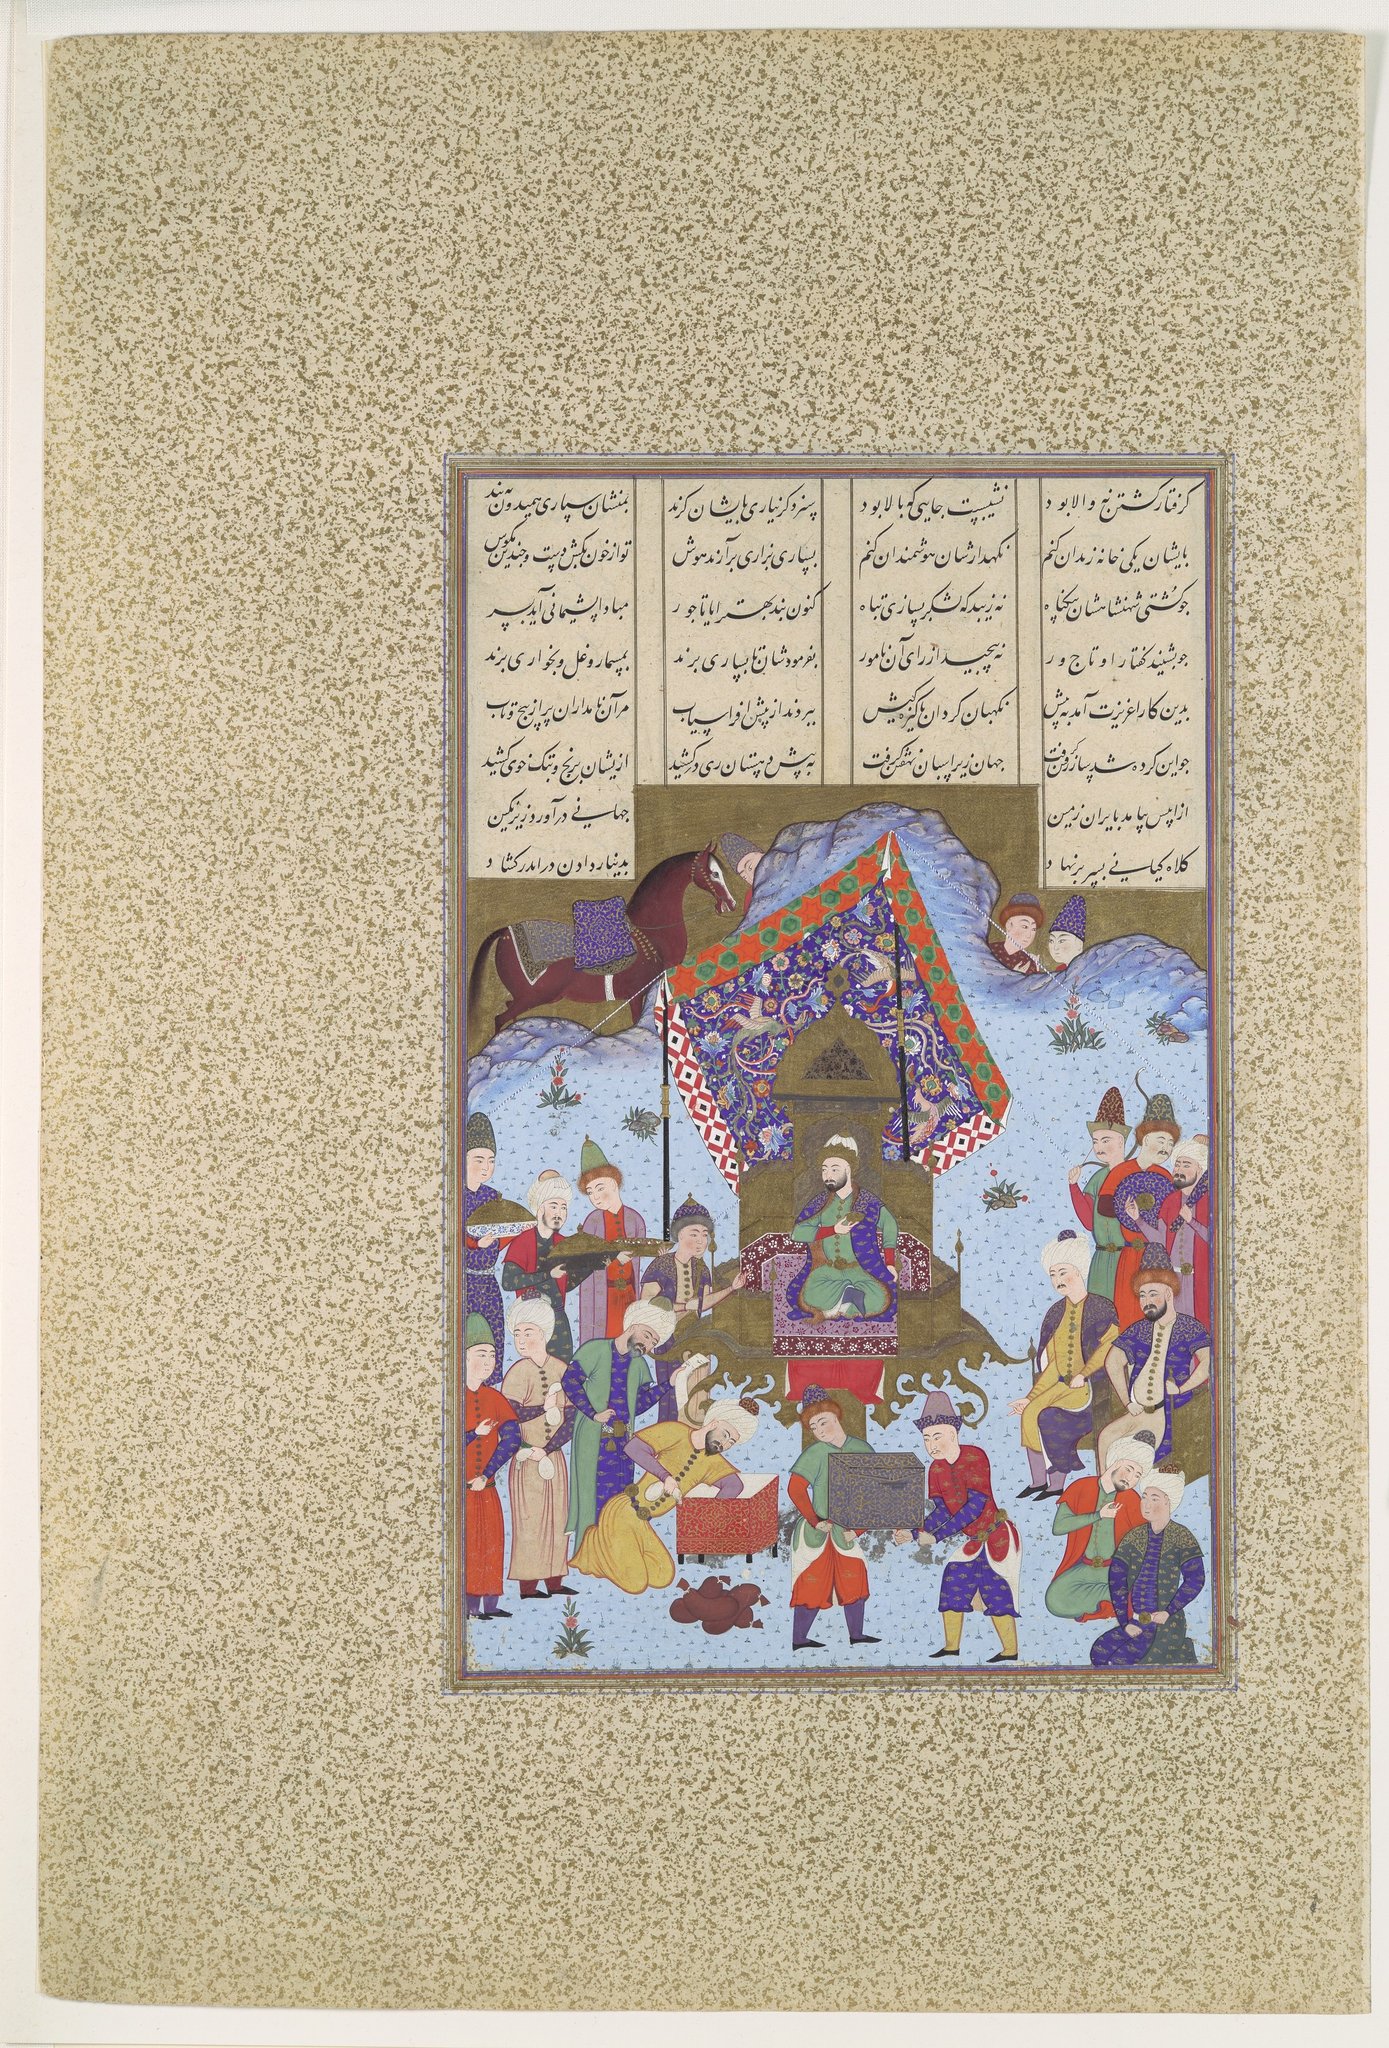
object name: folio from an illustrated manuscript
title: "Afrasiyab on the Iranian Throne", Folio 105r from the Shahnama (Book of Kings) of Shah Tahmasp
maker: abu'l qasim firdausi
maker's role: author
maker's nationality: iranian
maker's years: 935-1020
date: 1525-1530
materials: gold, ink, paper, silver, watercolor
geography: iran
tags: poetry,men,horses